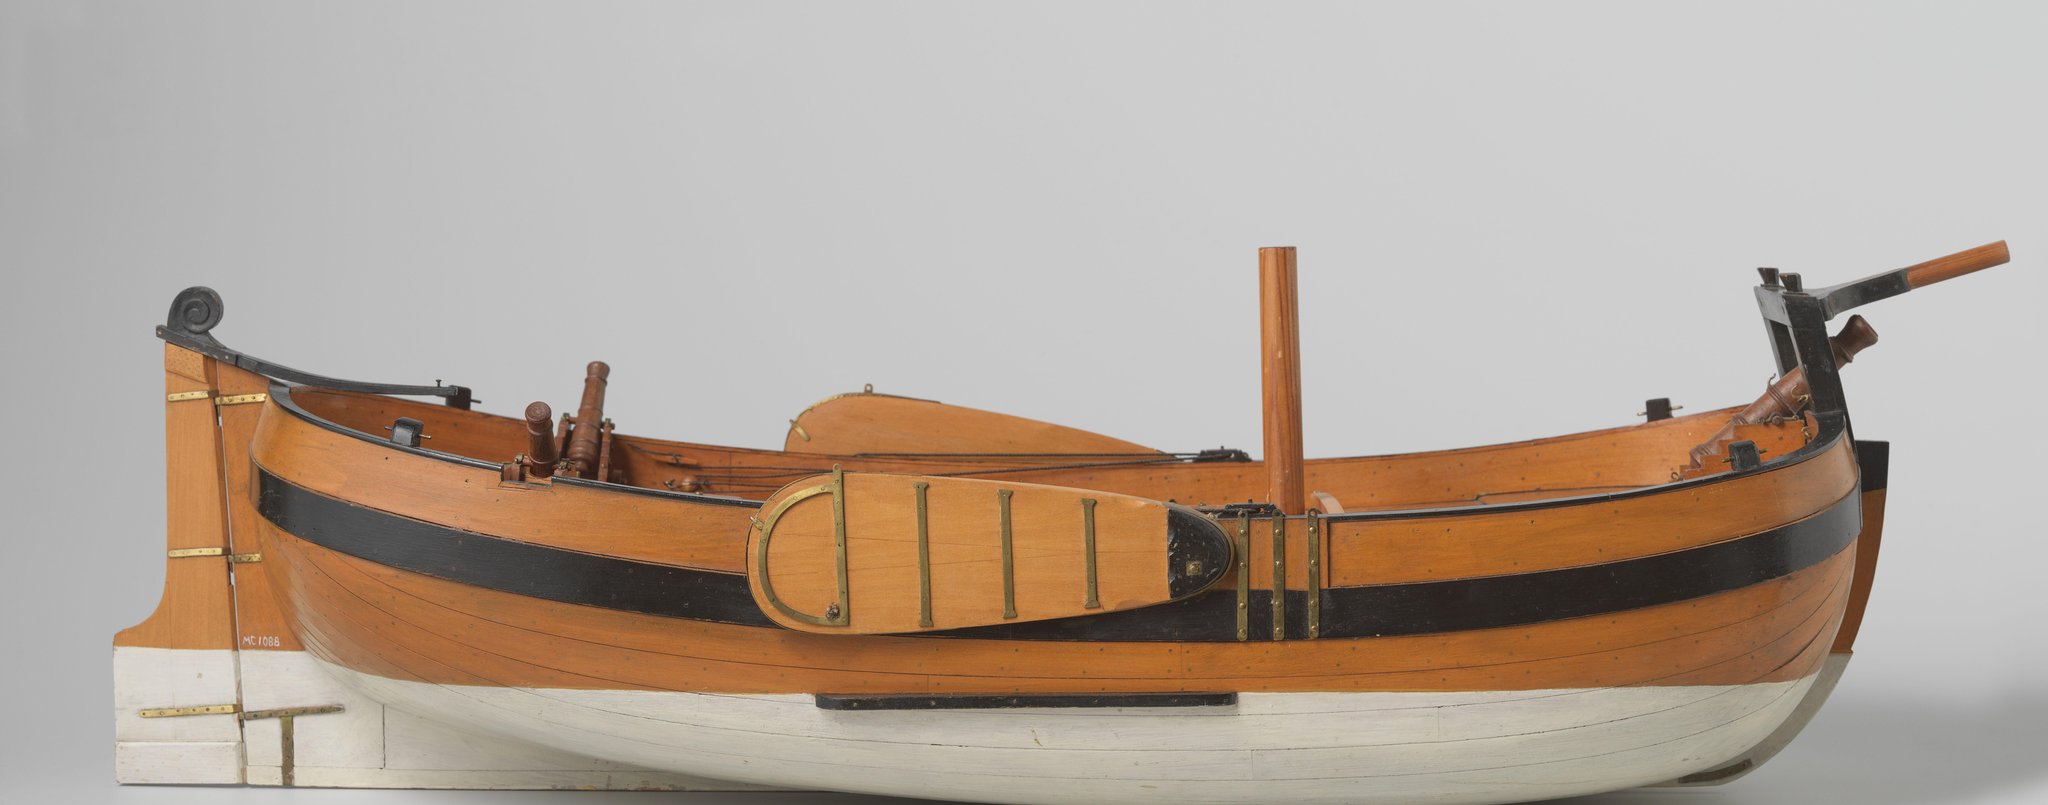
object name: demonstration model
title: Model of a Gunboat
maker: Anonymous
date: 1800-1825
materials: brass, paint, fiber, wood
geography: netherlands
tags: ship-model (+ propulsion of vehicle, ship, etc. by wind)